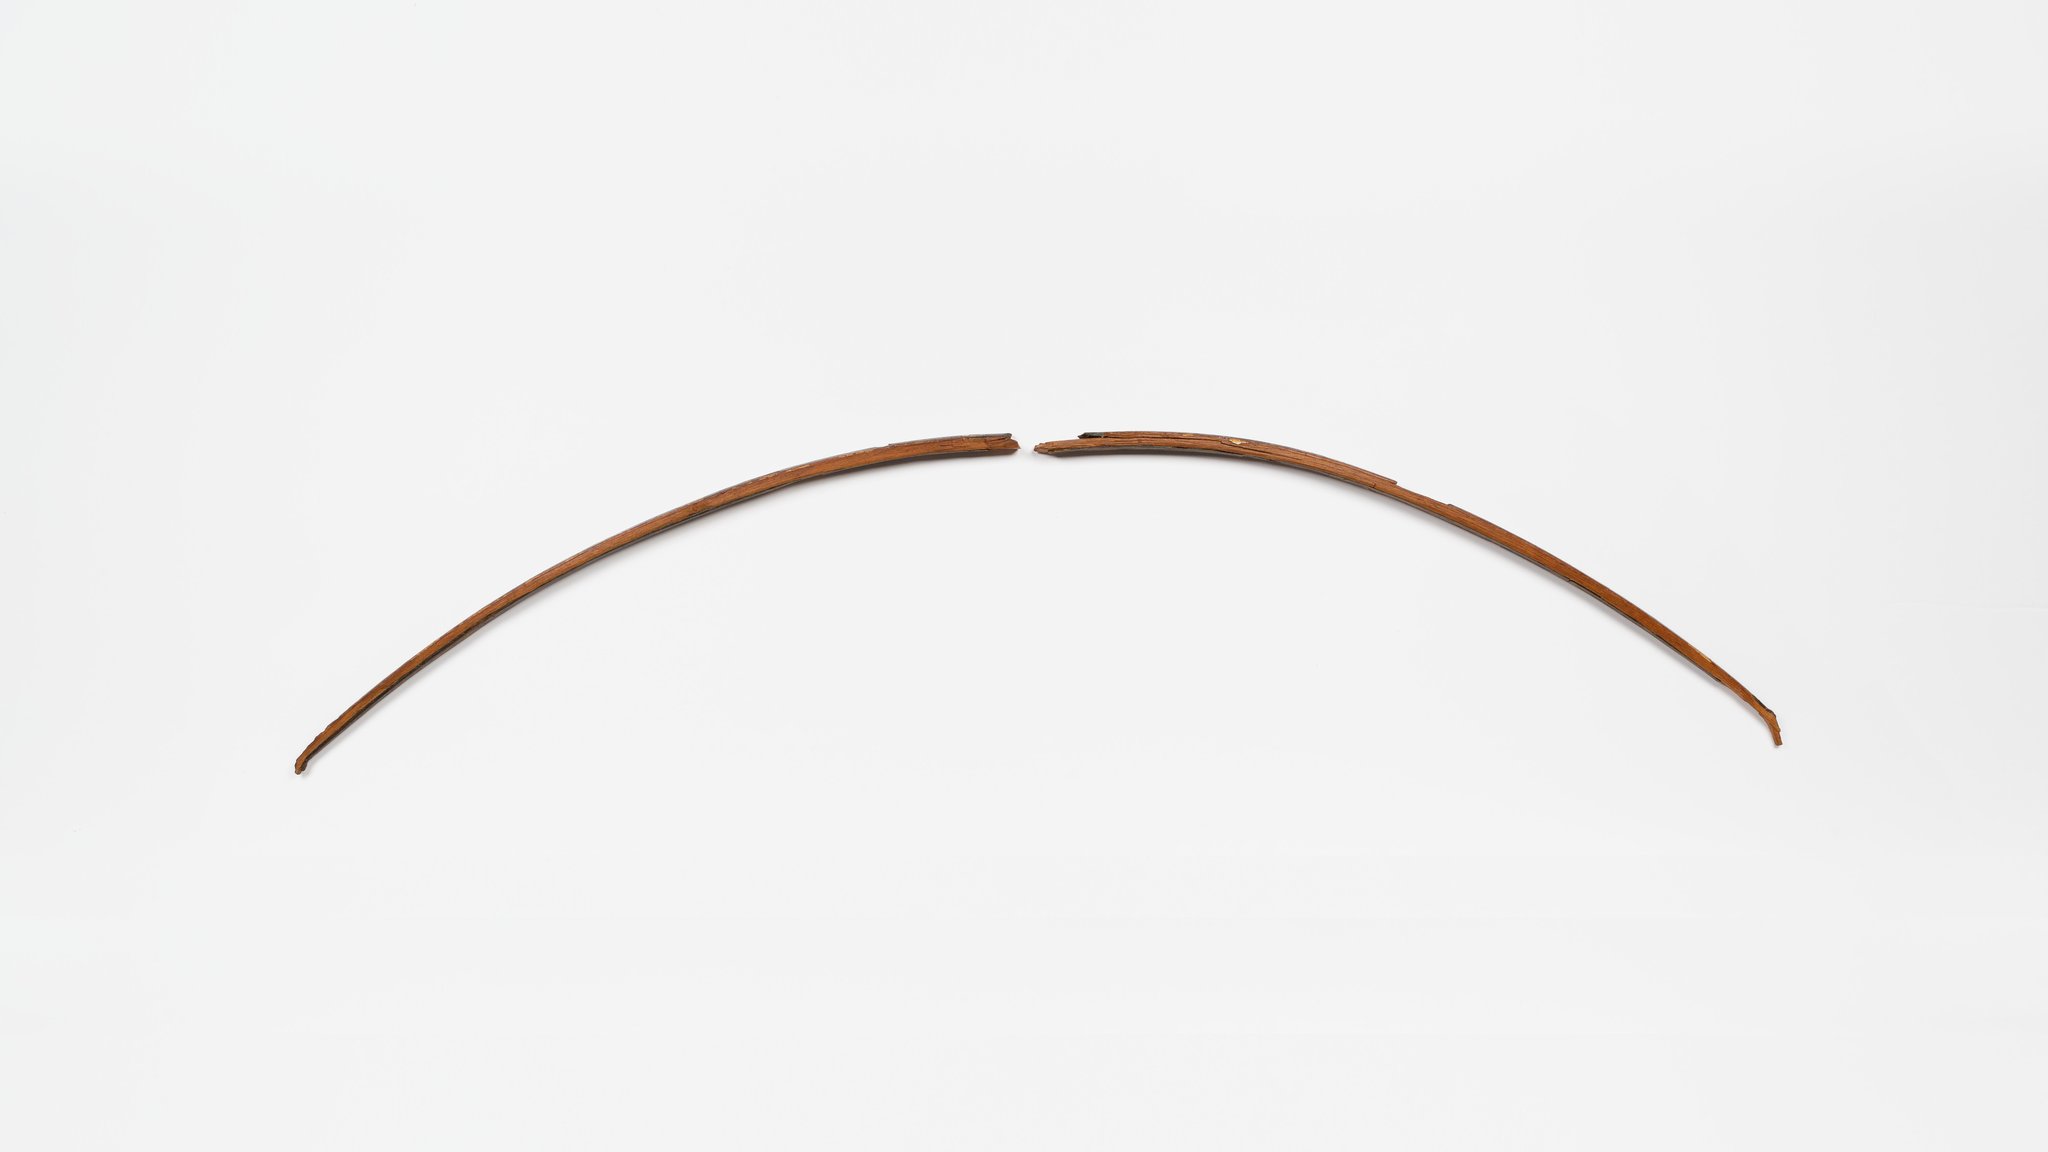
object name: bow, composite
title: Two Sections of a Composite Bow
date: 1550-1295 BCE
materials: wood, horn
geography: egypt